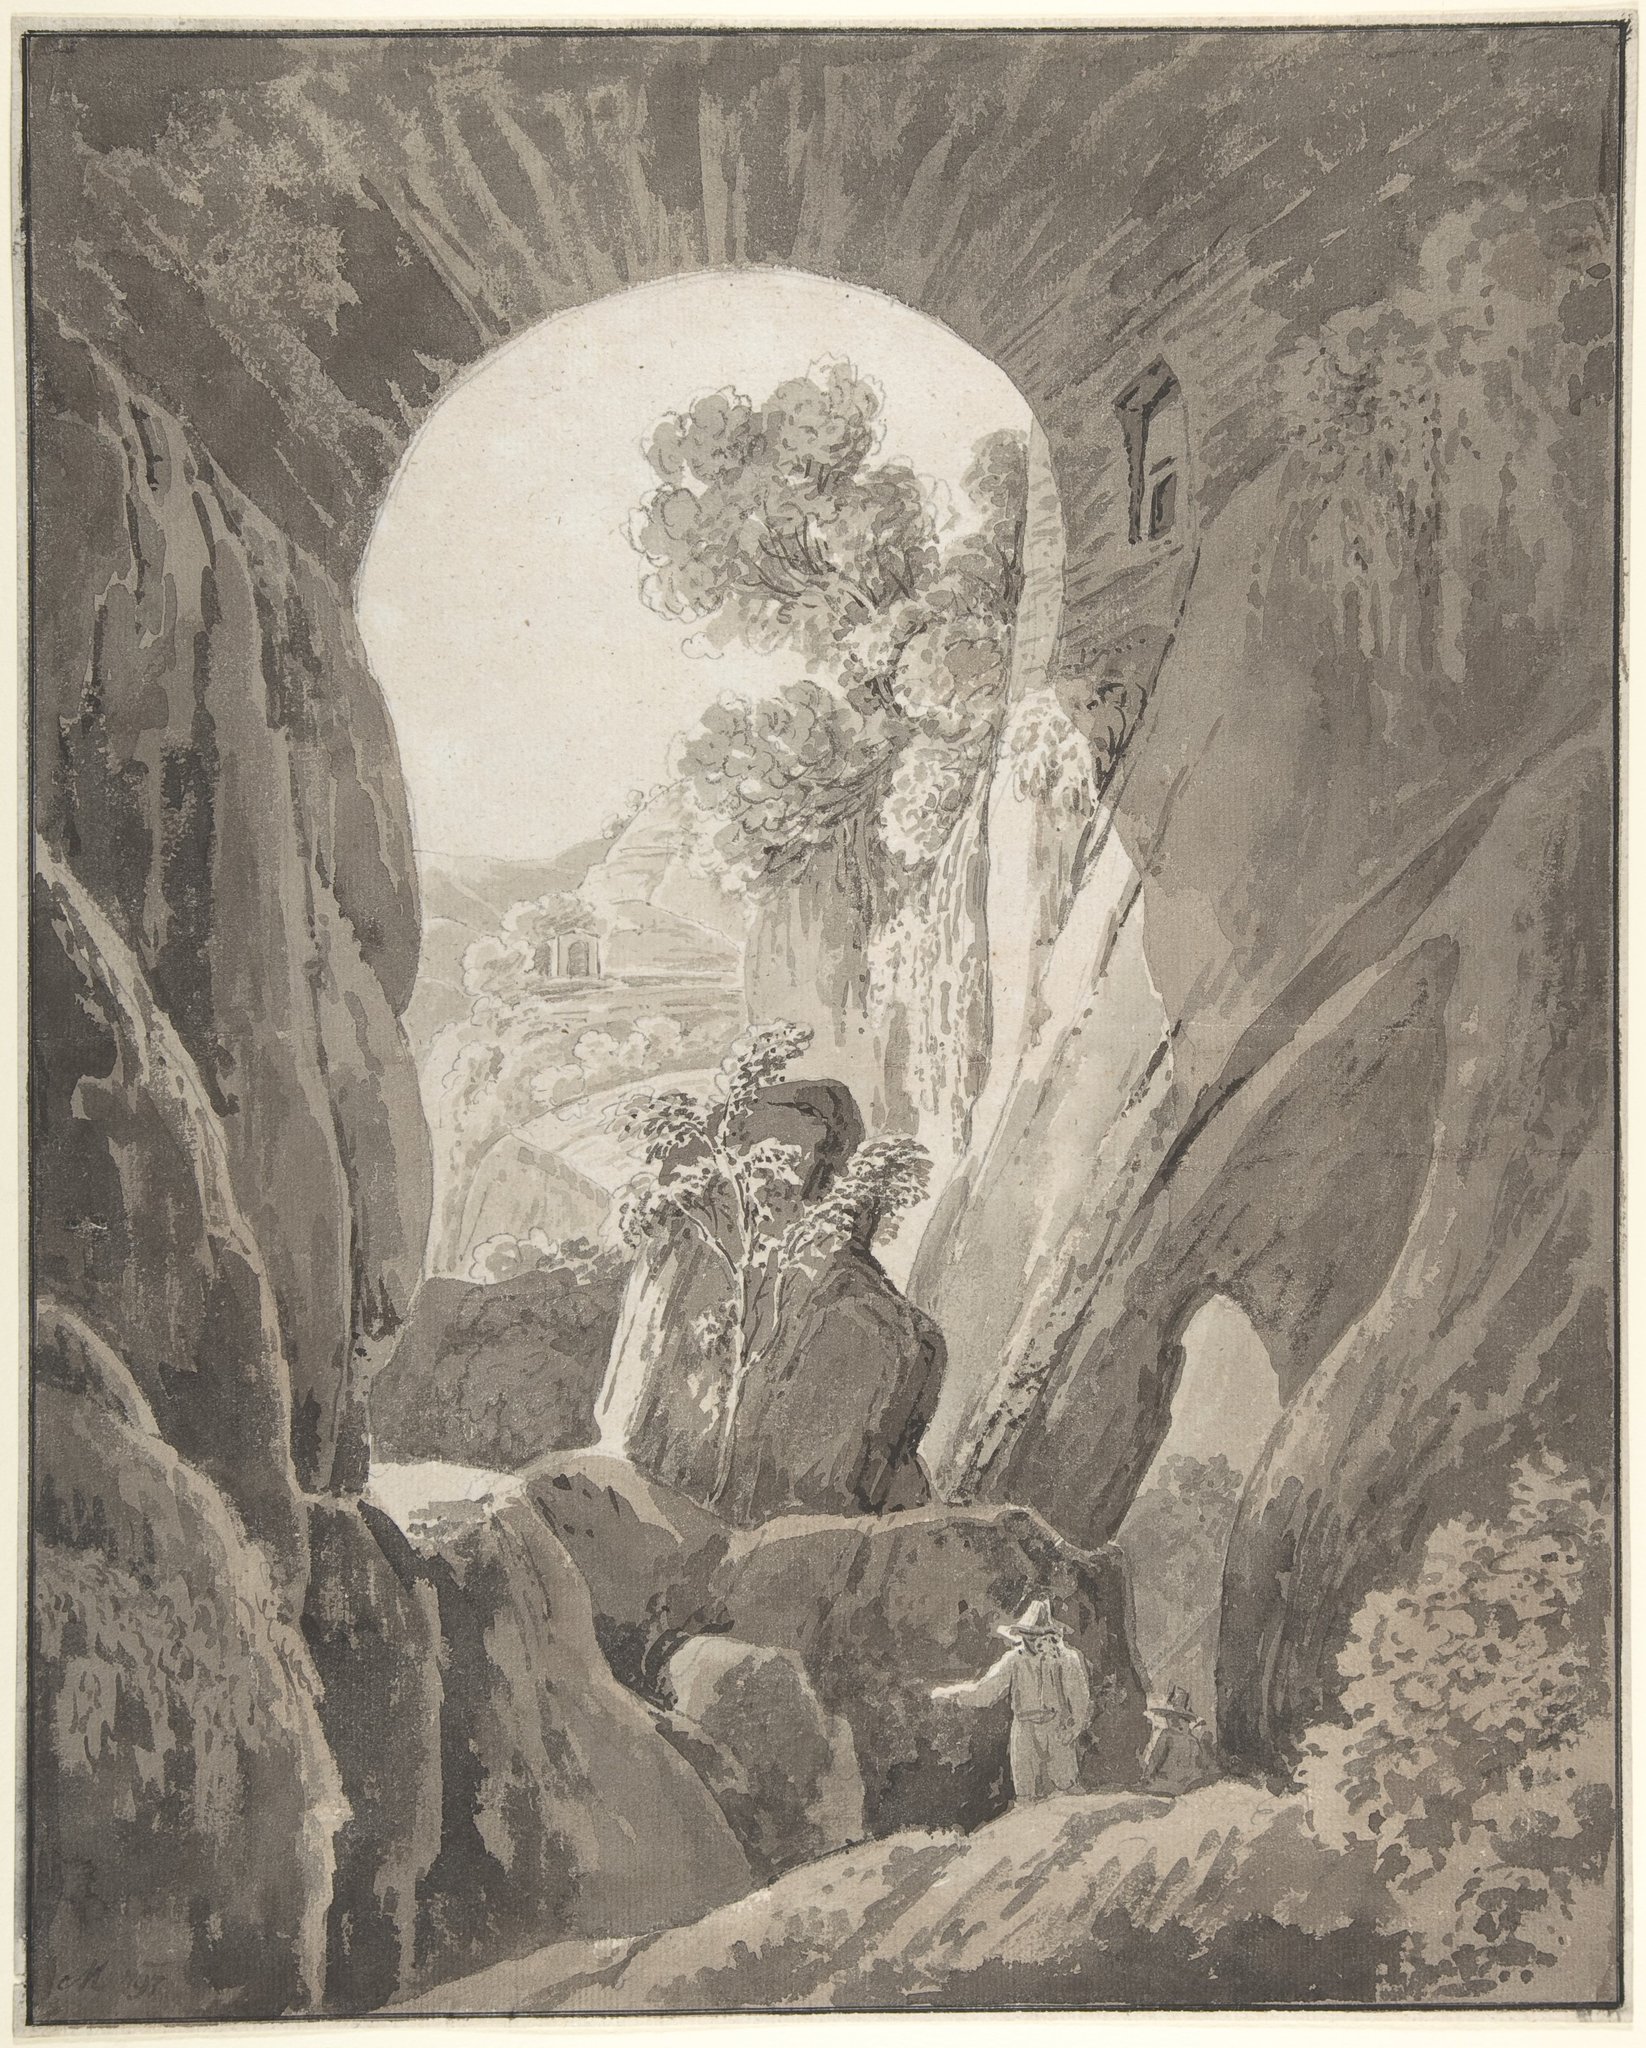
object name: drawing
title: The Caves of Acradina near Syracuse in Sicily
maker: jacob wilhelm mechau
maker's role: artist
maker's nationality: german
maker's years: 1745-1808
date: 1797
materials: chalk, ink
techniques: brush, pen, wash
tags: men,caves,trees